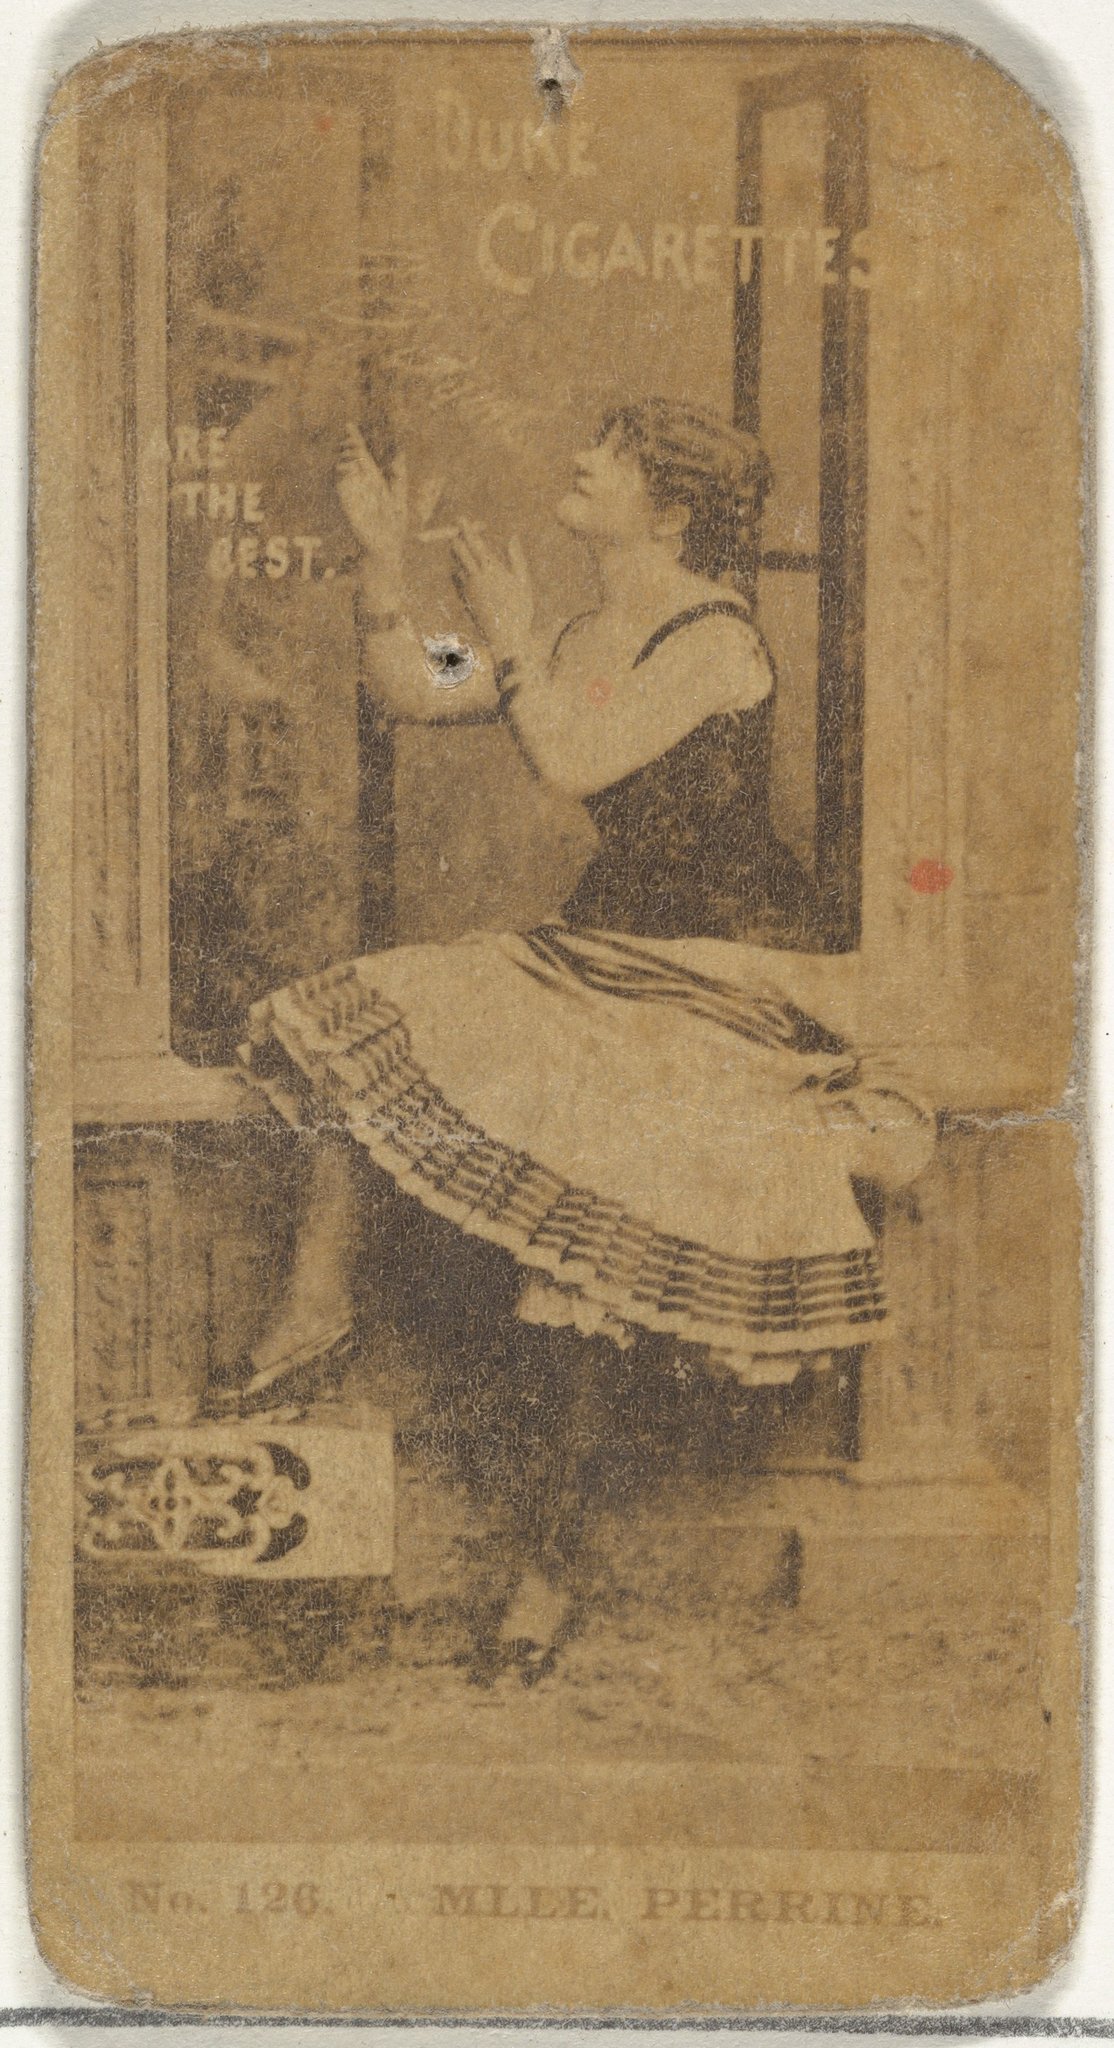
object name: photograph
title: Card Number 126, Mlle. Perrine, from the Actors and Actresses series (N145-6) issued by Duke Sons & Co. to promote Duke Cigarettes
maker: w. duke, sons & co.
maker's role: publisher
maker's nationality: american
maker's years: 1870-1920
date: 1880-1889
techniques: albumen silver print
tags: women,actresses